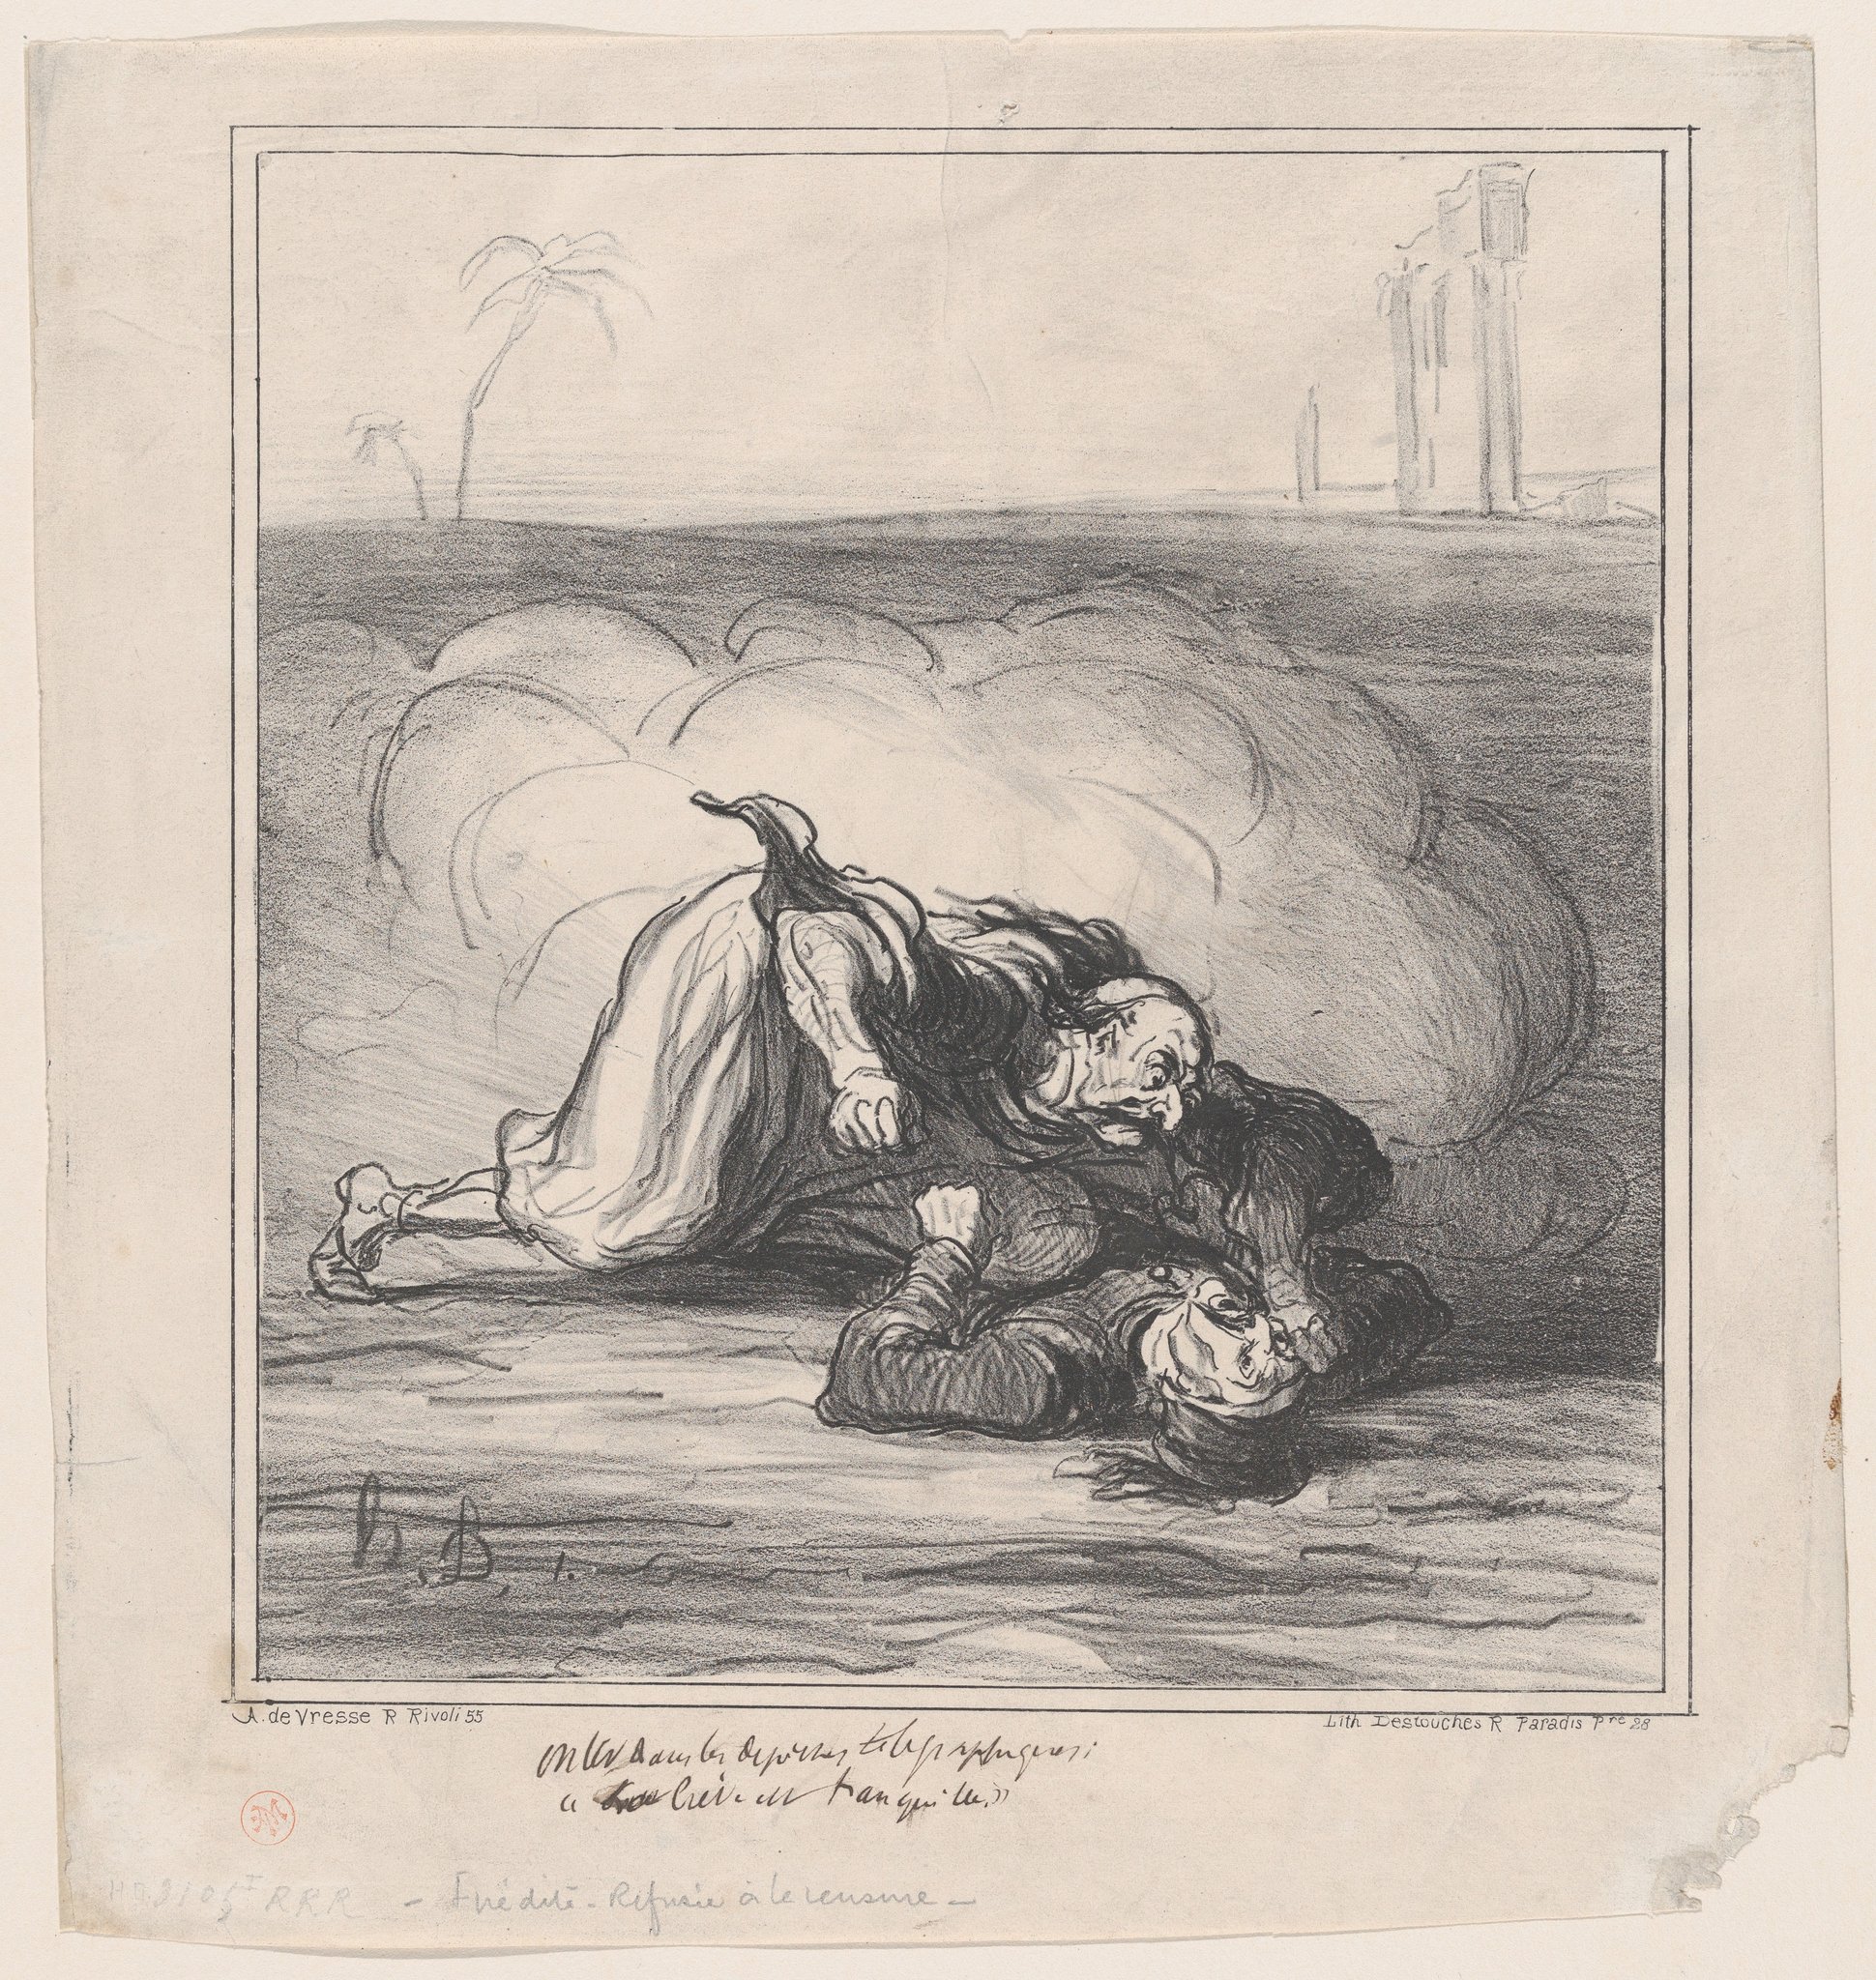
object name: print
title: A pair of friends, from 'News of the day,' published in "Le Charivari"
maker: honoré daumier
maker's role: artist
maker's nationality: french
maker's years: 1808-1879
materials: ink, paper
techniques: lithograph, pen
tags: men